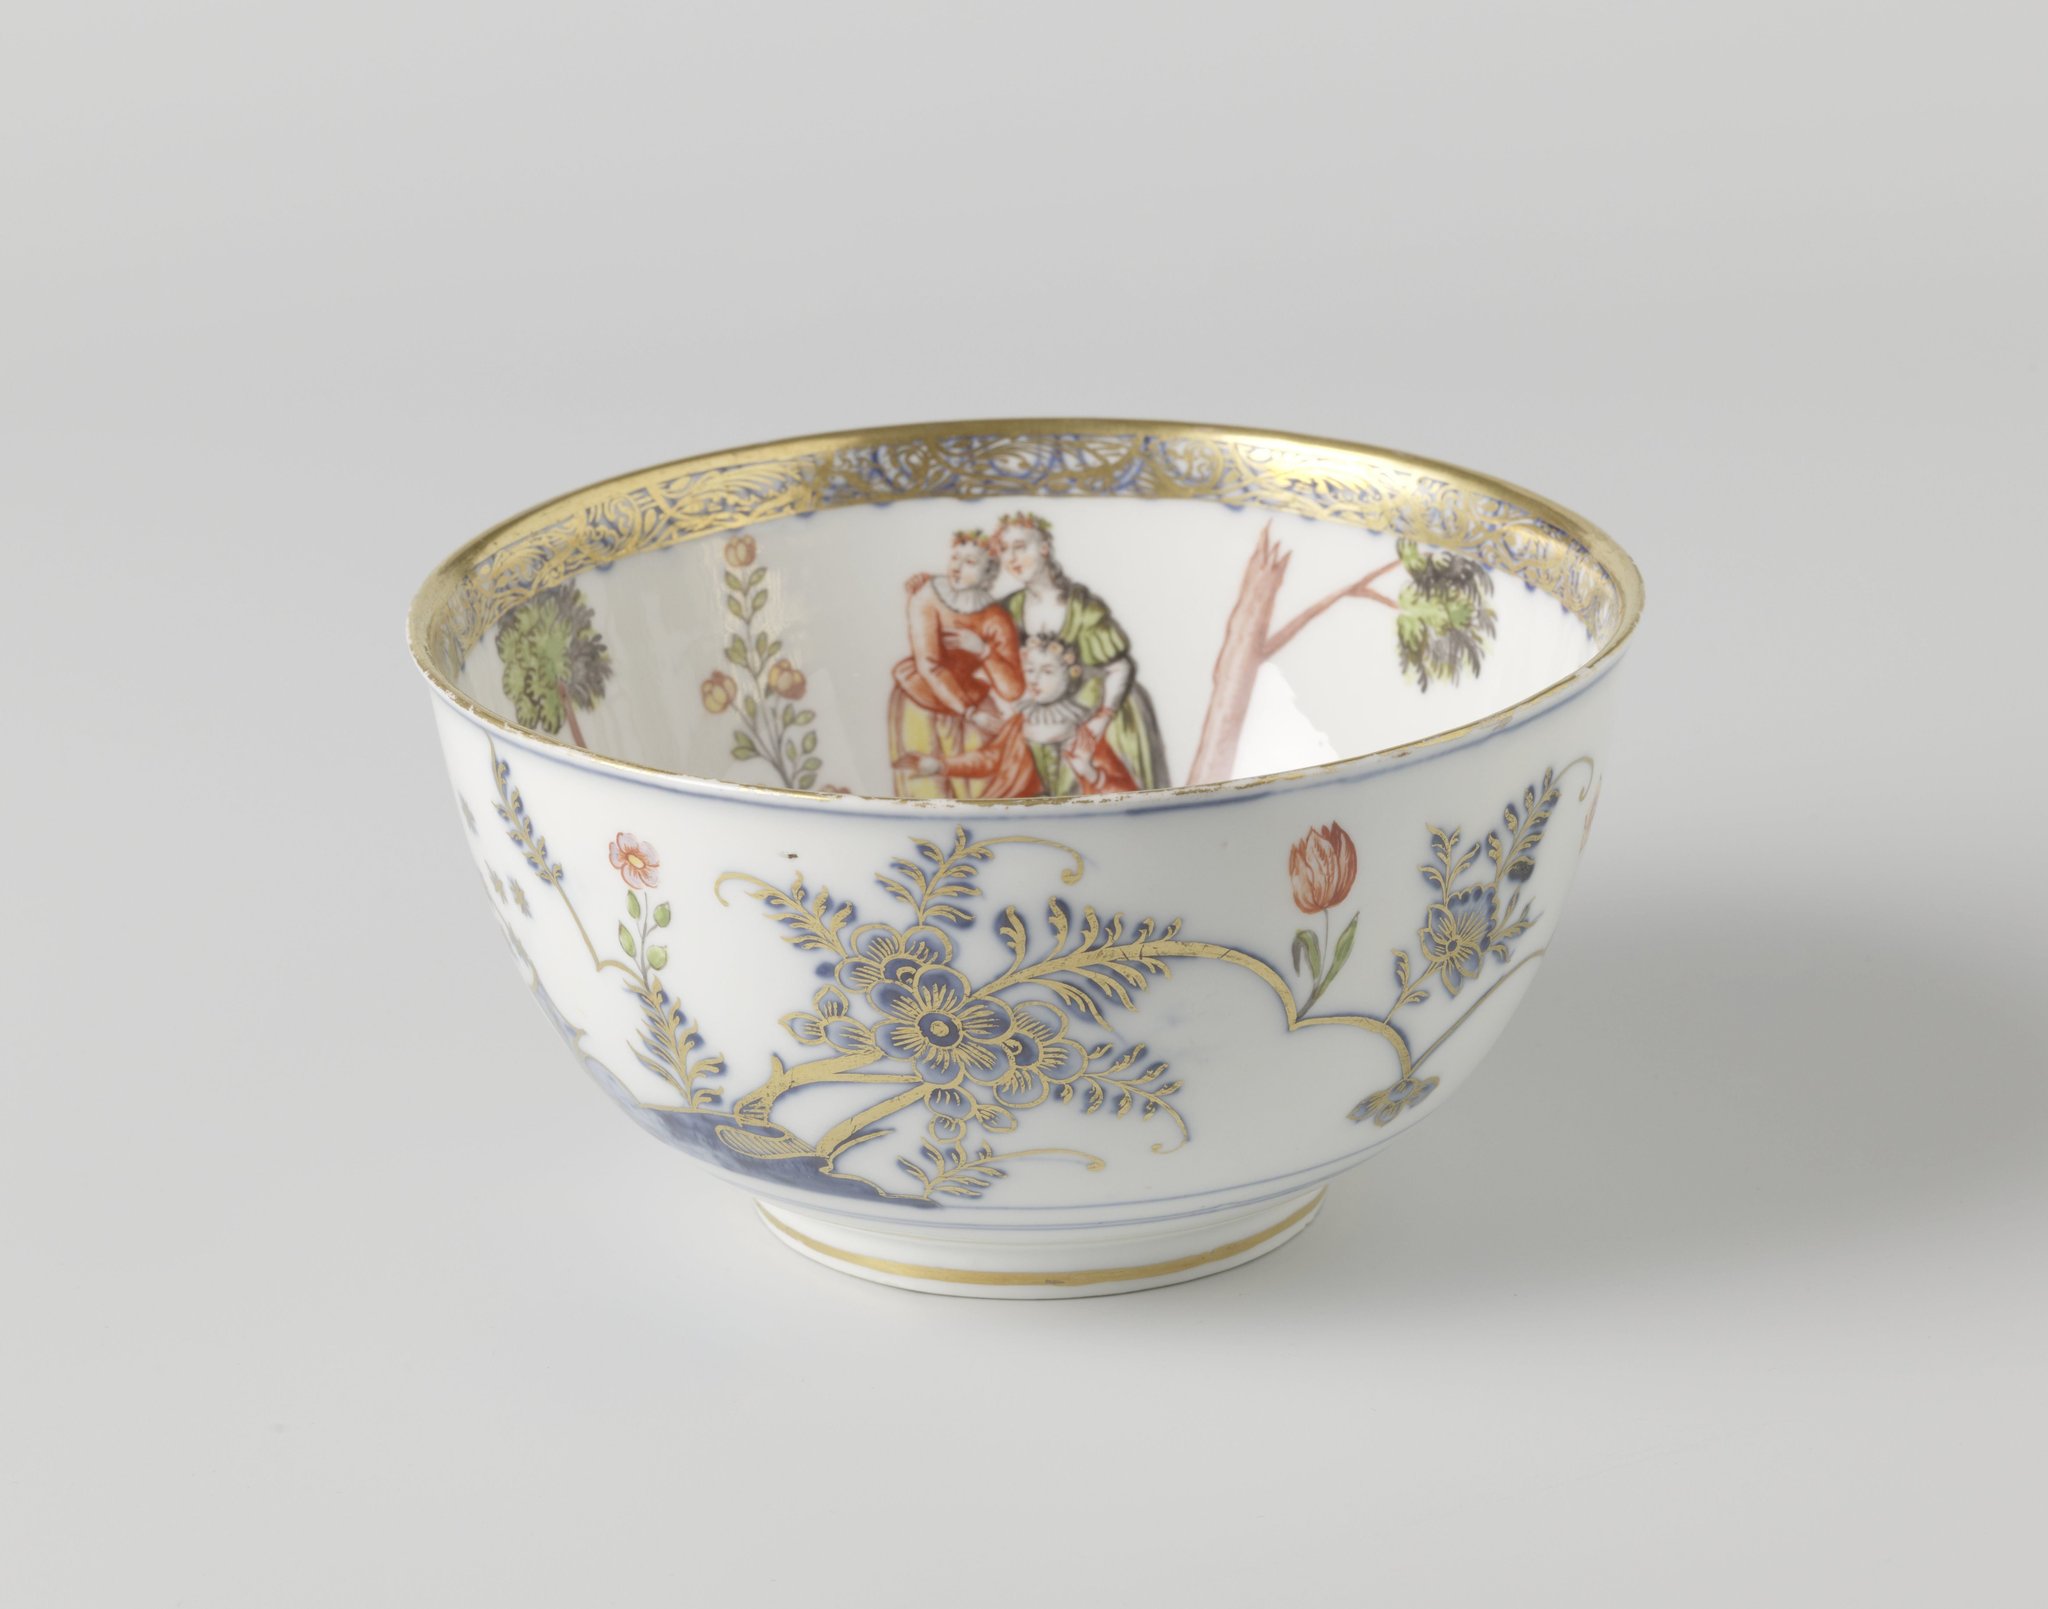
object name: slop bowl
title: Spoelkom, veelkleurig beschilderd met dieren en liefdesparen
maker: f.j. ferner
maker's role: porseleinschilder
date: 1730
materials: porcelain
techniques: painted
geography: schwarzburg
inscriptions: mark: ‘B (of R?)’, factory mark, mark: ‘3’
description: Slop basin. Porcelain. Meissen, c. 1730, decorated by the 'Hausmaler' F.J. Ferner.